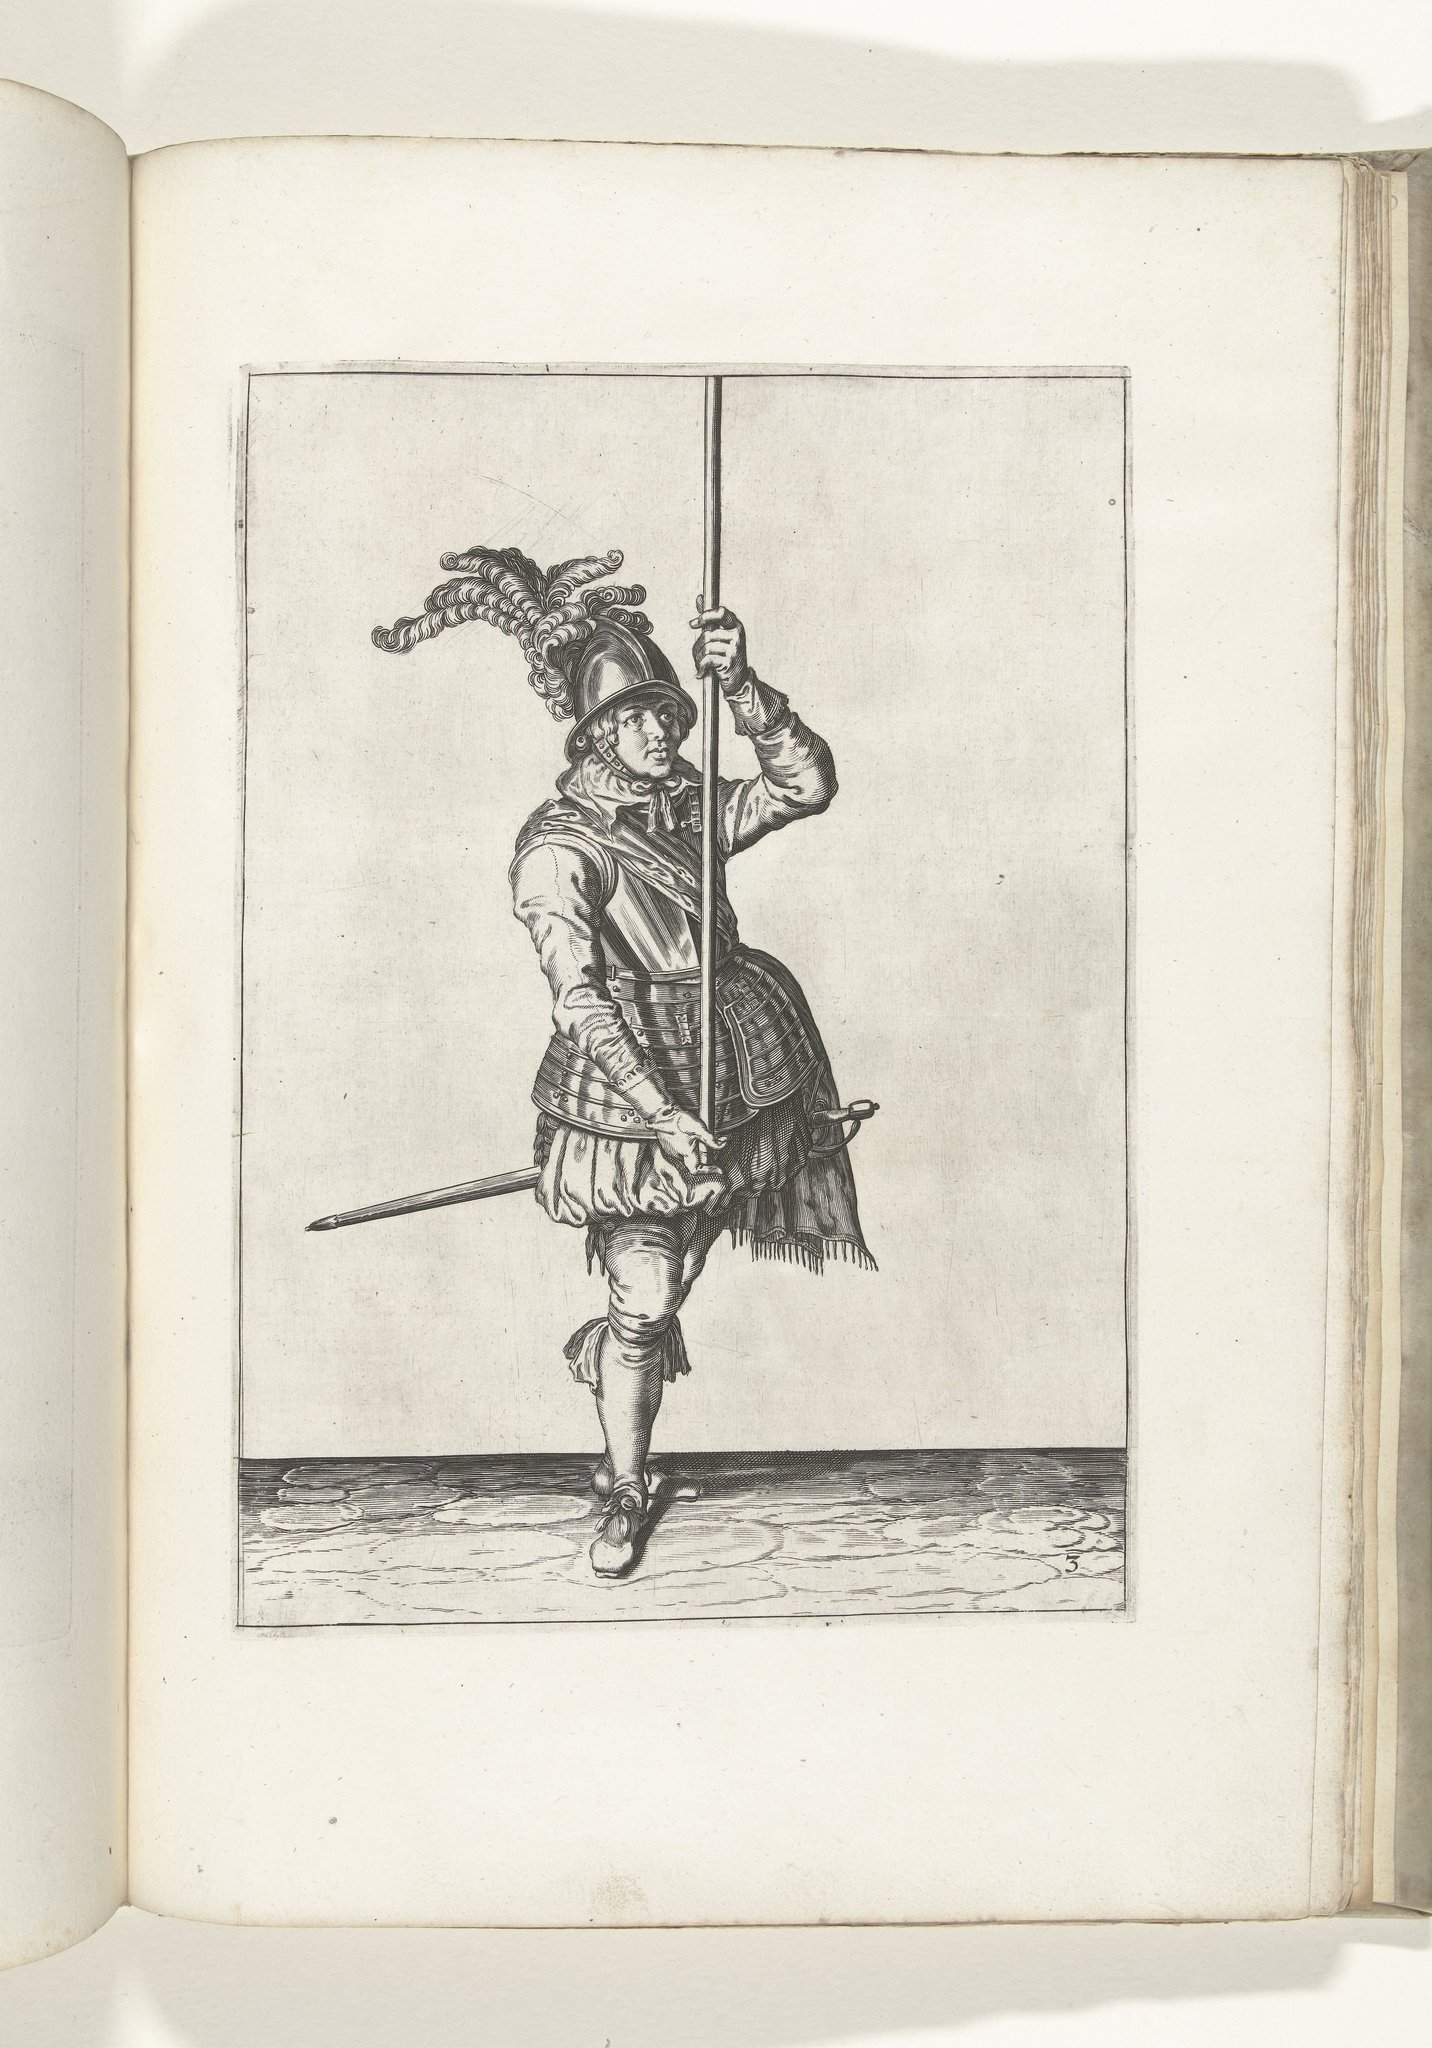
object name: print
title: Soldaat die zijn spies met beide handen rechtop voor zich hoog boven de grond vasthoudt (nr. 3), ca. 1600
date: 1597-1607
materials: paper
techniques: engraving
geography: northern netherlands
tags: maurice (prince of orange), handling of weapons ~ military training, weapons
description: Een soldaat, ten voeten uit, die een spies (lans) met beide handen rechtop voor zich hoog boven de grond vasthoudt (nr. 3), ca. 1600. Dit is de tweede handeling voor het rechtop opheffen van de spies. Plaat 3 in de instructies voor het hanteren van de spies: Corte onderwysinghe op de figuerliicke afbeeldinghe, belanghende t'recht ghebruyck, van al t'ghene een Soldaet int handelen vande Spies noodich is. Onderdeel van de illustraties in: J. de Gheyn, Wapenhandelinghe van Roers Musquetten ende spiessen, 's-Gravenhage, 1607. Krijgswezen rond 1600.